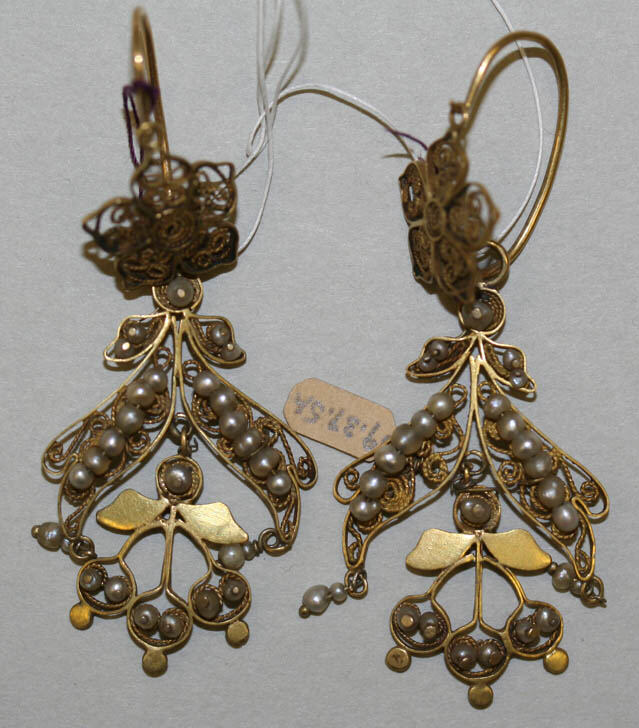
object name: earring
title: Earrings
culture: european, eastern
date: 1701-1900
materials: metal